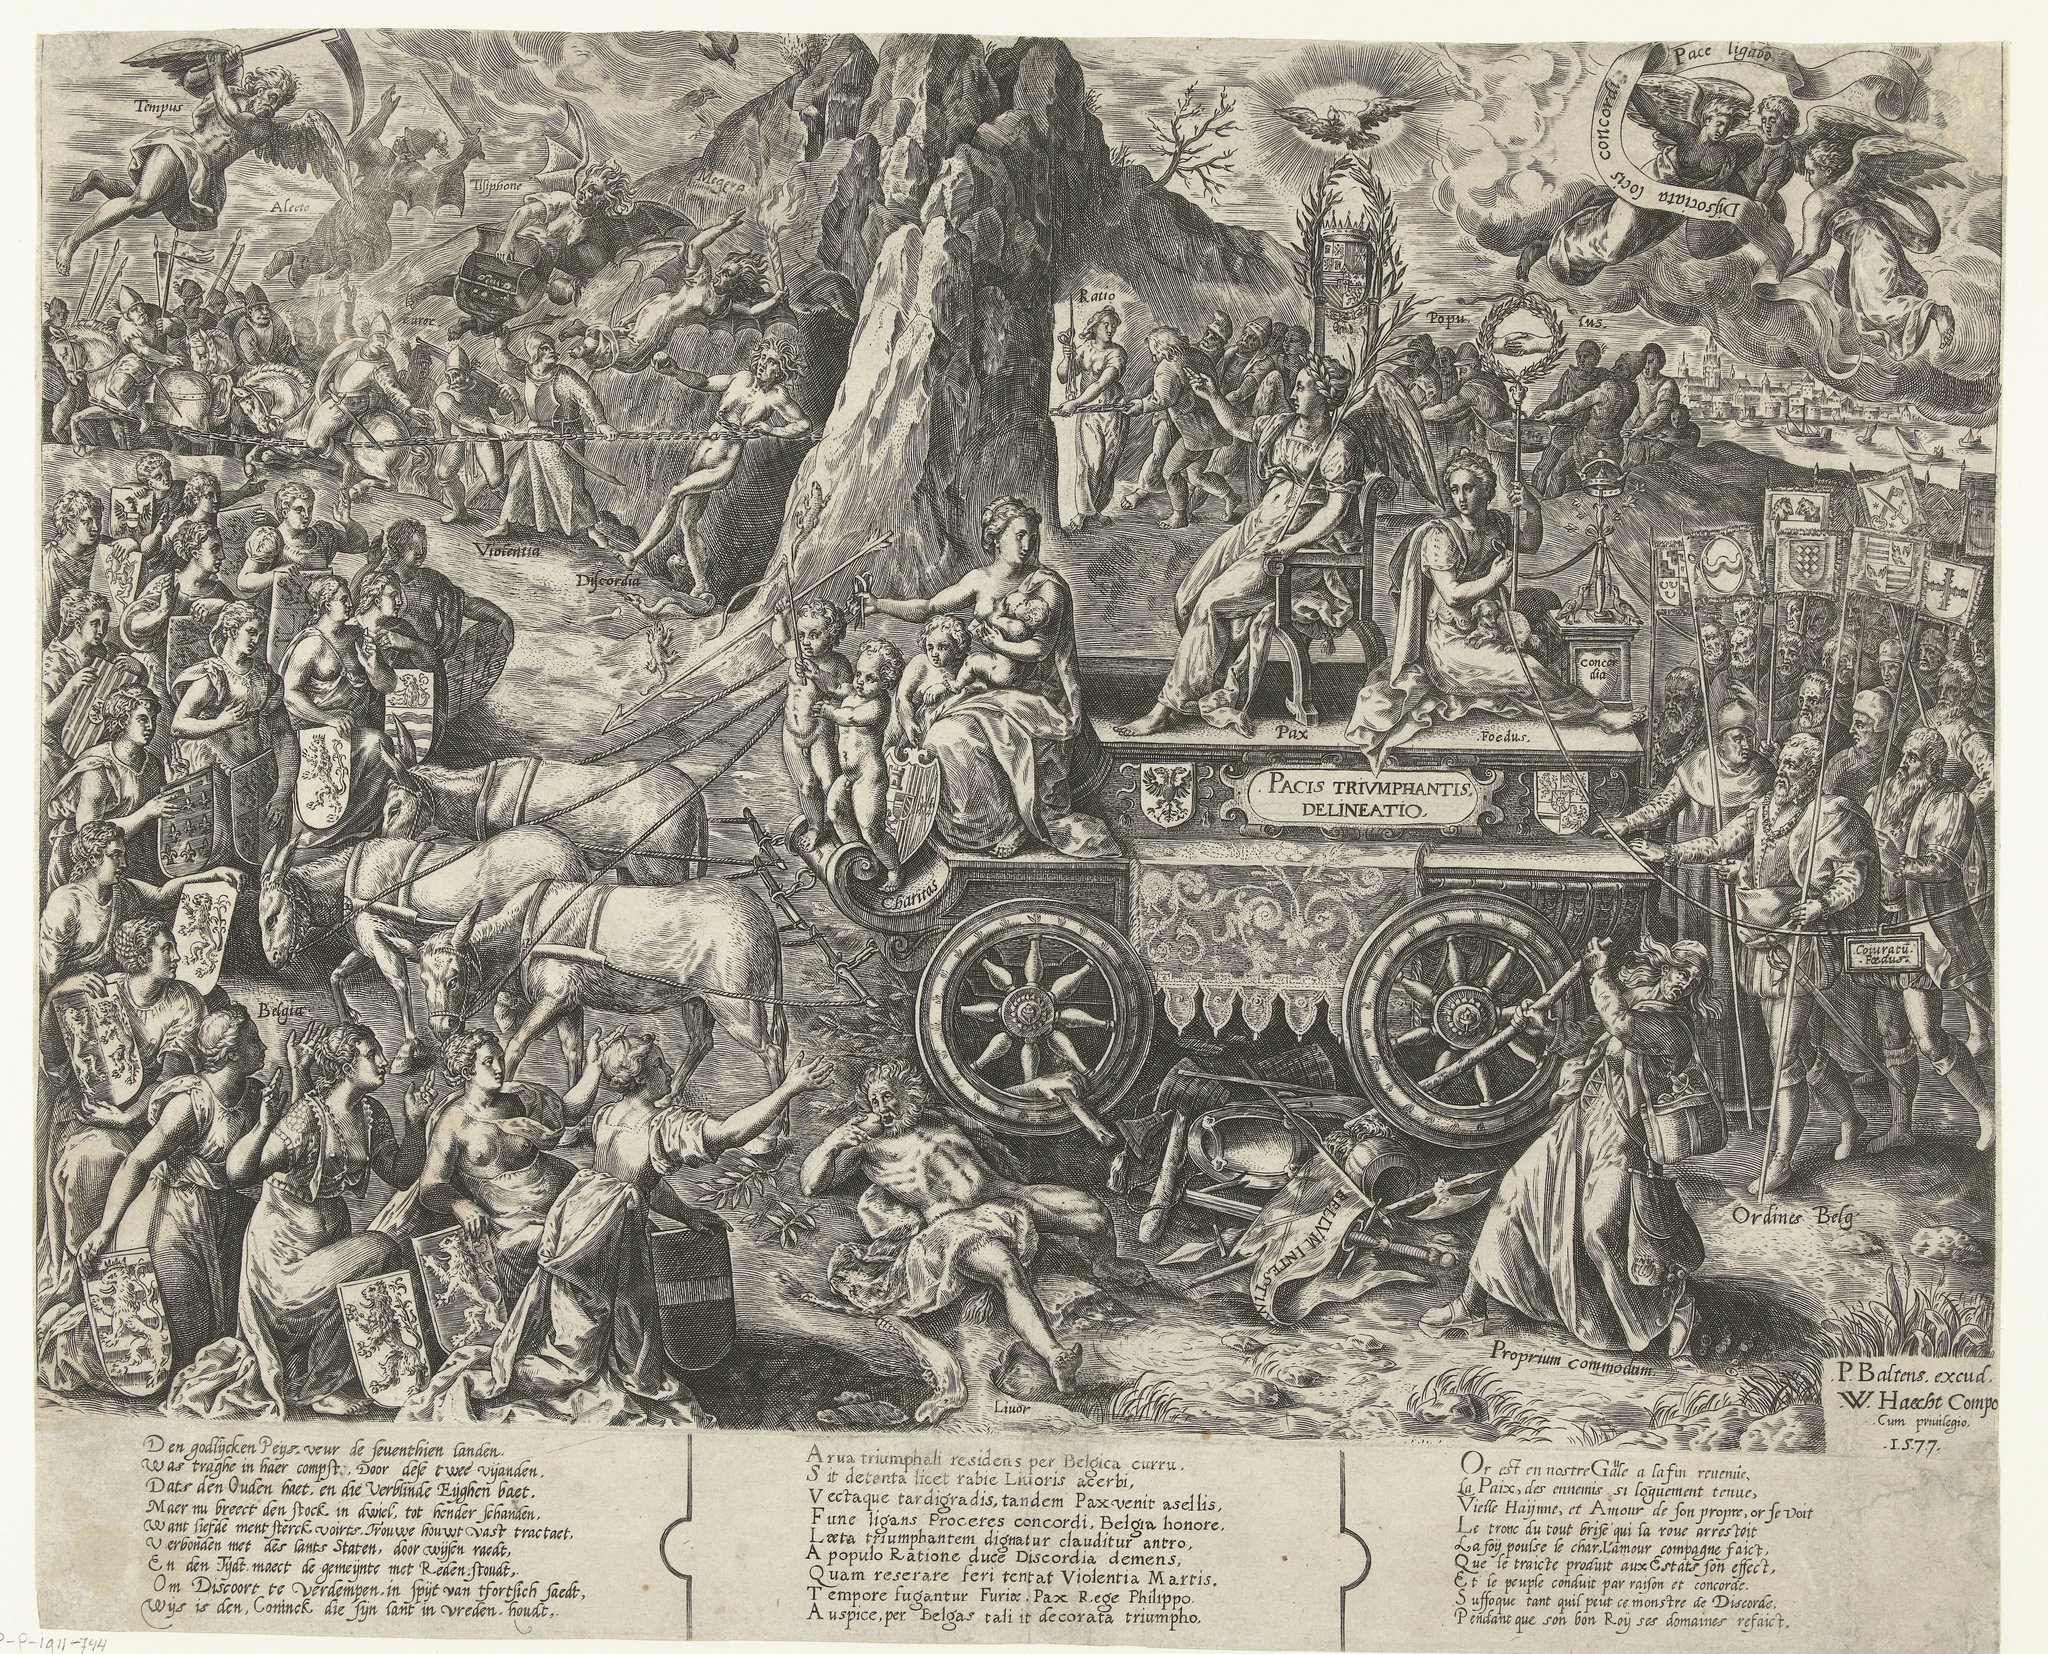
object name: propagandaprent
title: De triomfwagen van de vrede, 1577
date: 1577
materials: paper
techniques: engraving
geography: southern netherlands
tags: philip ii of spain, delft, william i (prince of orange), don juan van oostenrijk, agreement, unity; 'concordia', 'concordia insuperabile', 'concordia militare', 'concordia di pace', 'unione civile' (ripa), charity, 'caritas'; 'carità' (ripa) ~ one of the three theological virtues, symbols, allegories of peace, 'pax'; 'pace' (ripa), oath, chariot, triumphal car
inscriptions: date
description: Allegorie op de vrede gesloten met het Eeuwig Edict van 1577. De triomfwagen van de Vrede, getrokken door drie ezels. Op de wagen zittende vrouwelijk personificaties van Liefde (Charitas), Vrede (Pax) en Verbond (Foedus) en wapens van Filips II, Don Juan van Oostenrijk en Willem van Oranje. Links geknield de zeventien provinciemaagden. De Oude Haat (Livor) en Eigenbaat (Proprium commodum) proberen de voortgang van de wagen te verhinderen. Achter de wagen lopen de vertegenwoordigers van de Staten-Generaal. Op de achtergrond wordt Tweedracht (Discordia) gewurgd in een trekwedstrijd tussen de krachten van Geweld (Violentia) en het Volk (Populus). Onder de voorstelling op een aparte plaat 3 verzen van elk 9 regels in het Nederlands, Latijn en Frans.